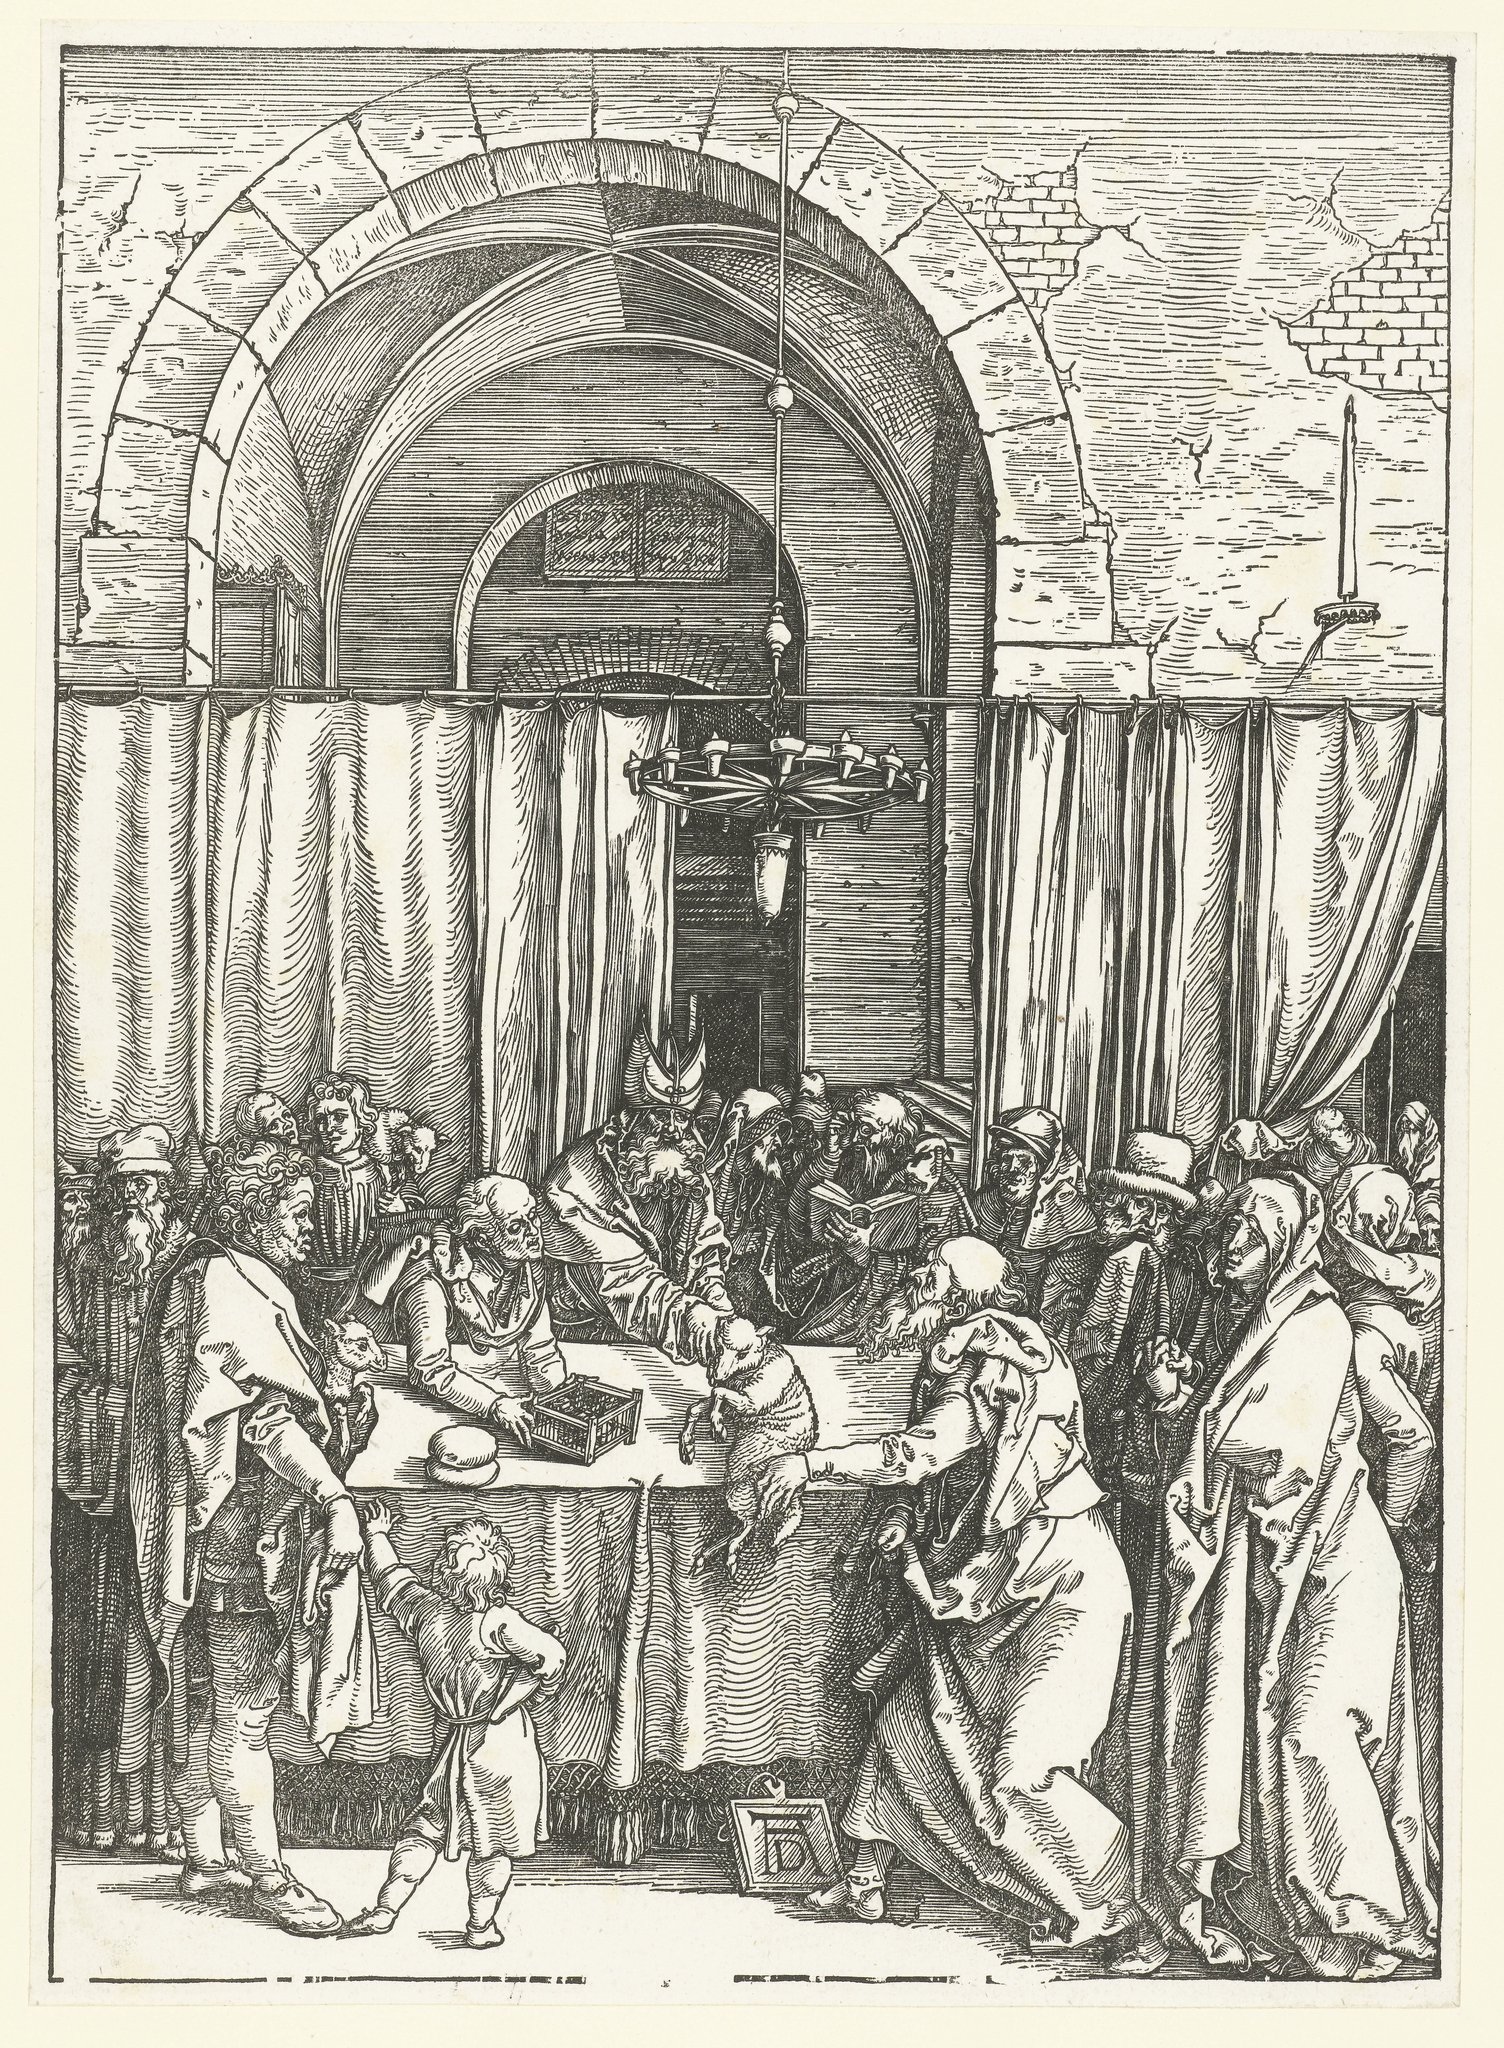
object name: print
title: Leven van Maria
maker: albrecht dürer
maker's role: draughtsman, painter, print maker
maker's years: 1471-1528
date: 1502-1506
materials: paper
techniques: woodcut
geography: nuremberg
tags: joachim's and anna's sacrifice refused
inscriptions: inscription: ‘Geoffreerd aande Teken Akademie / der stadt Amsterdam / 1788 P...’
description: Joachim staat met Anna bij een tafel, waaromheen veel mensen staan. De hogepriester achter de tafel duwt het lam dat Joachim aanbiedt van de tafel af. Deze prent is onderdeel van een serie van 20 prenten, bestaand uit een titelprent en 19 prenten met scènes uit het leven van Maria.